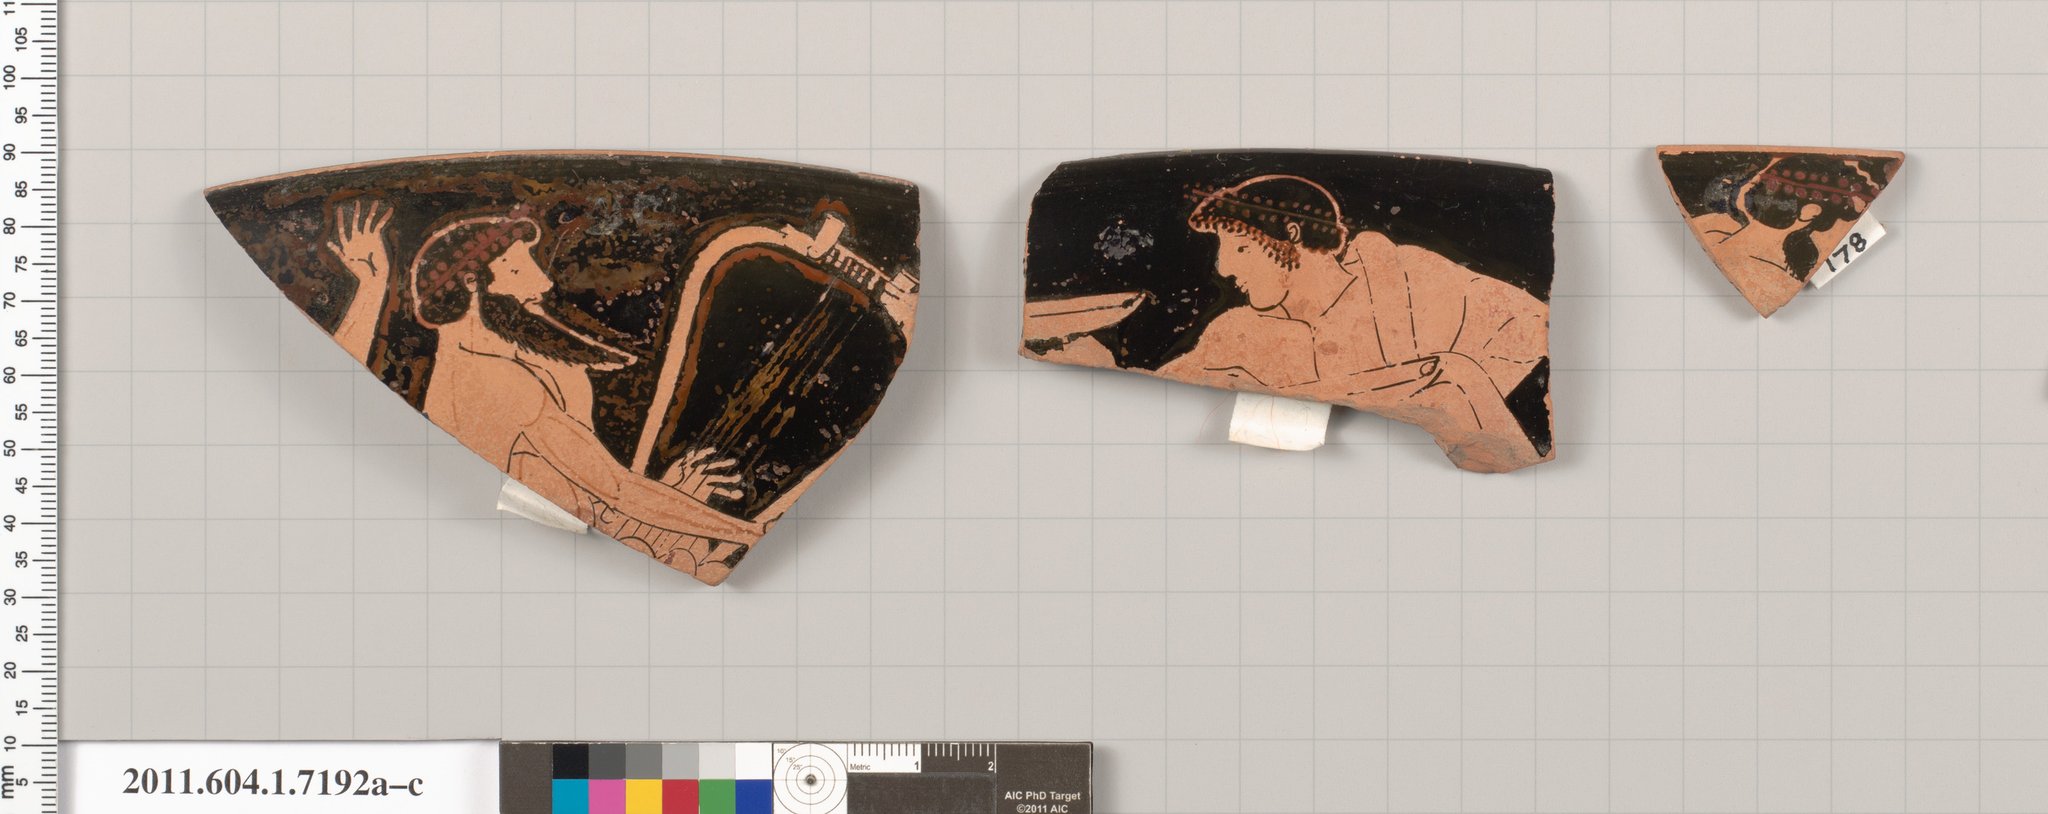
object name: kylix fragment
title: Terracotta rim fragments of a kylix (drinking cup)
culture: greek, attic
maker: makron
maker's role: artist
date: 500-480 BCE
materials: terracotta